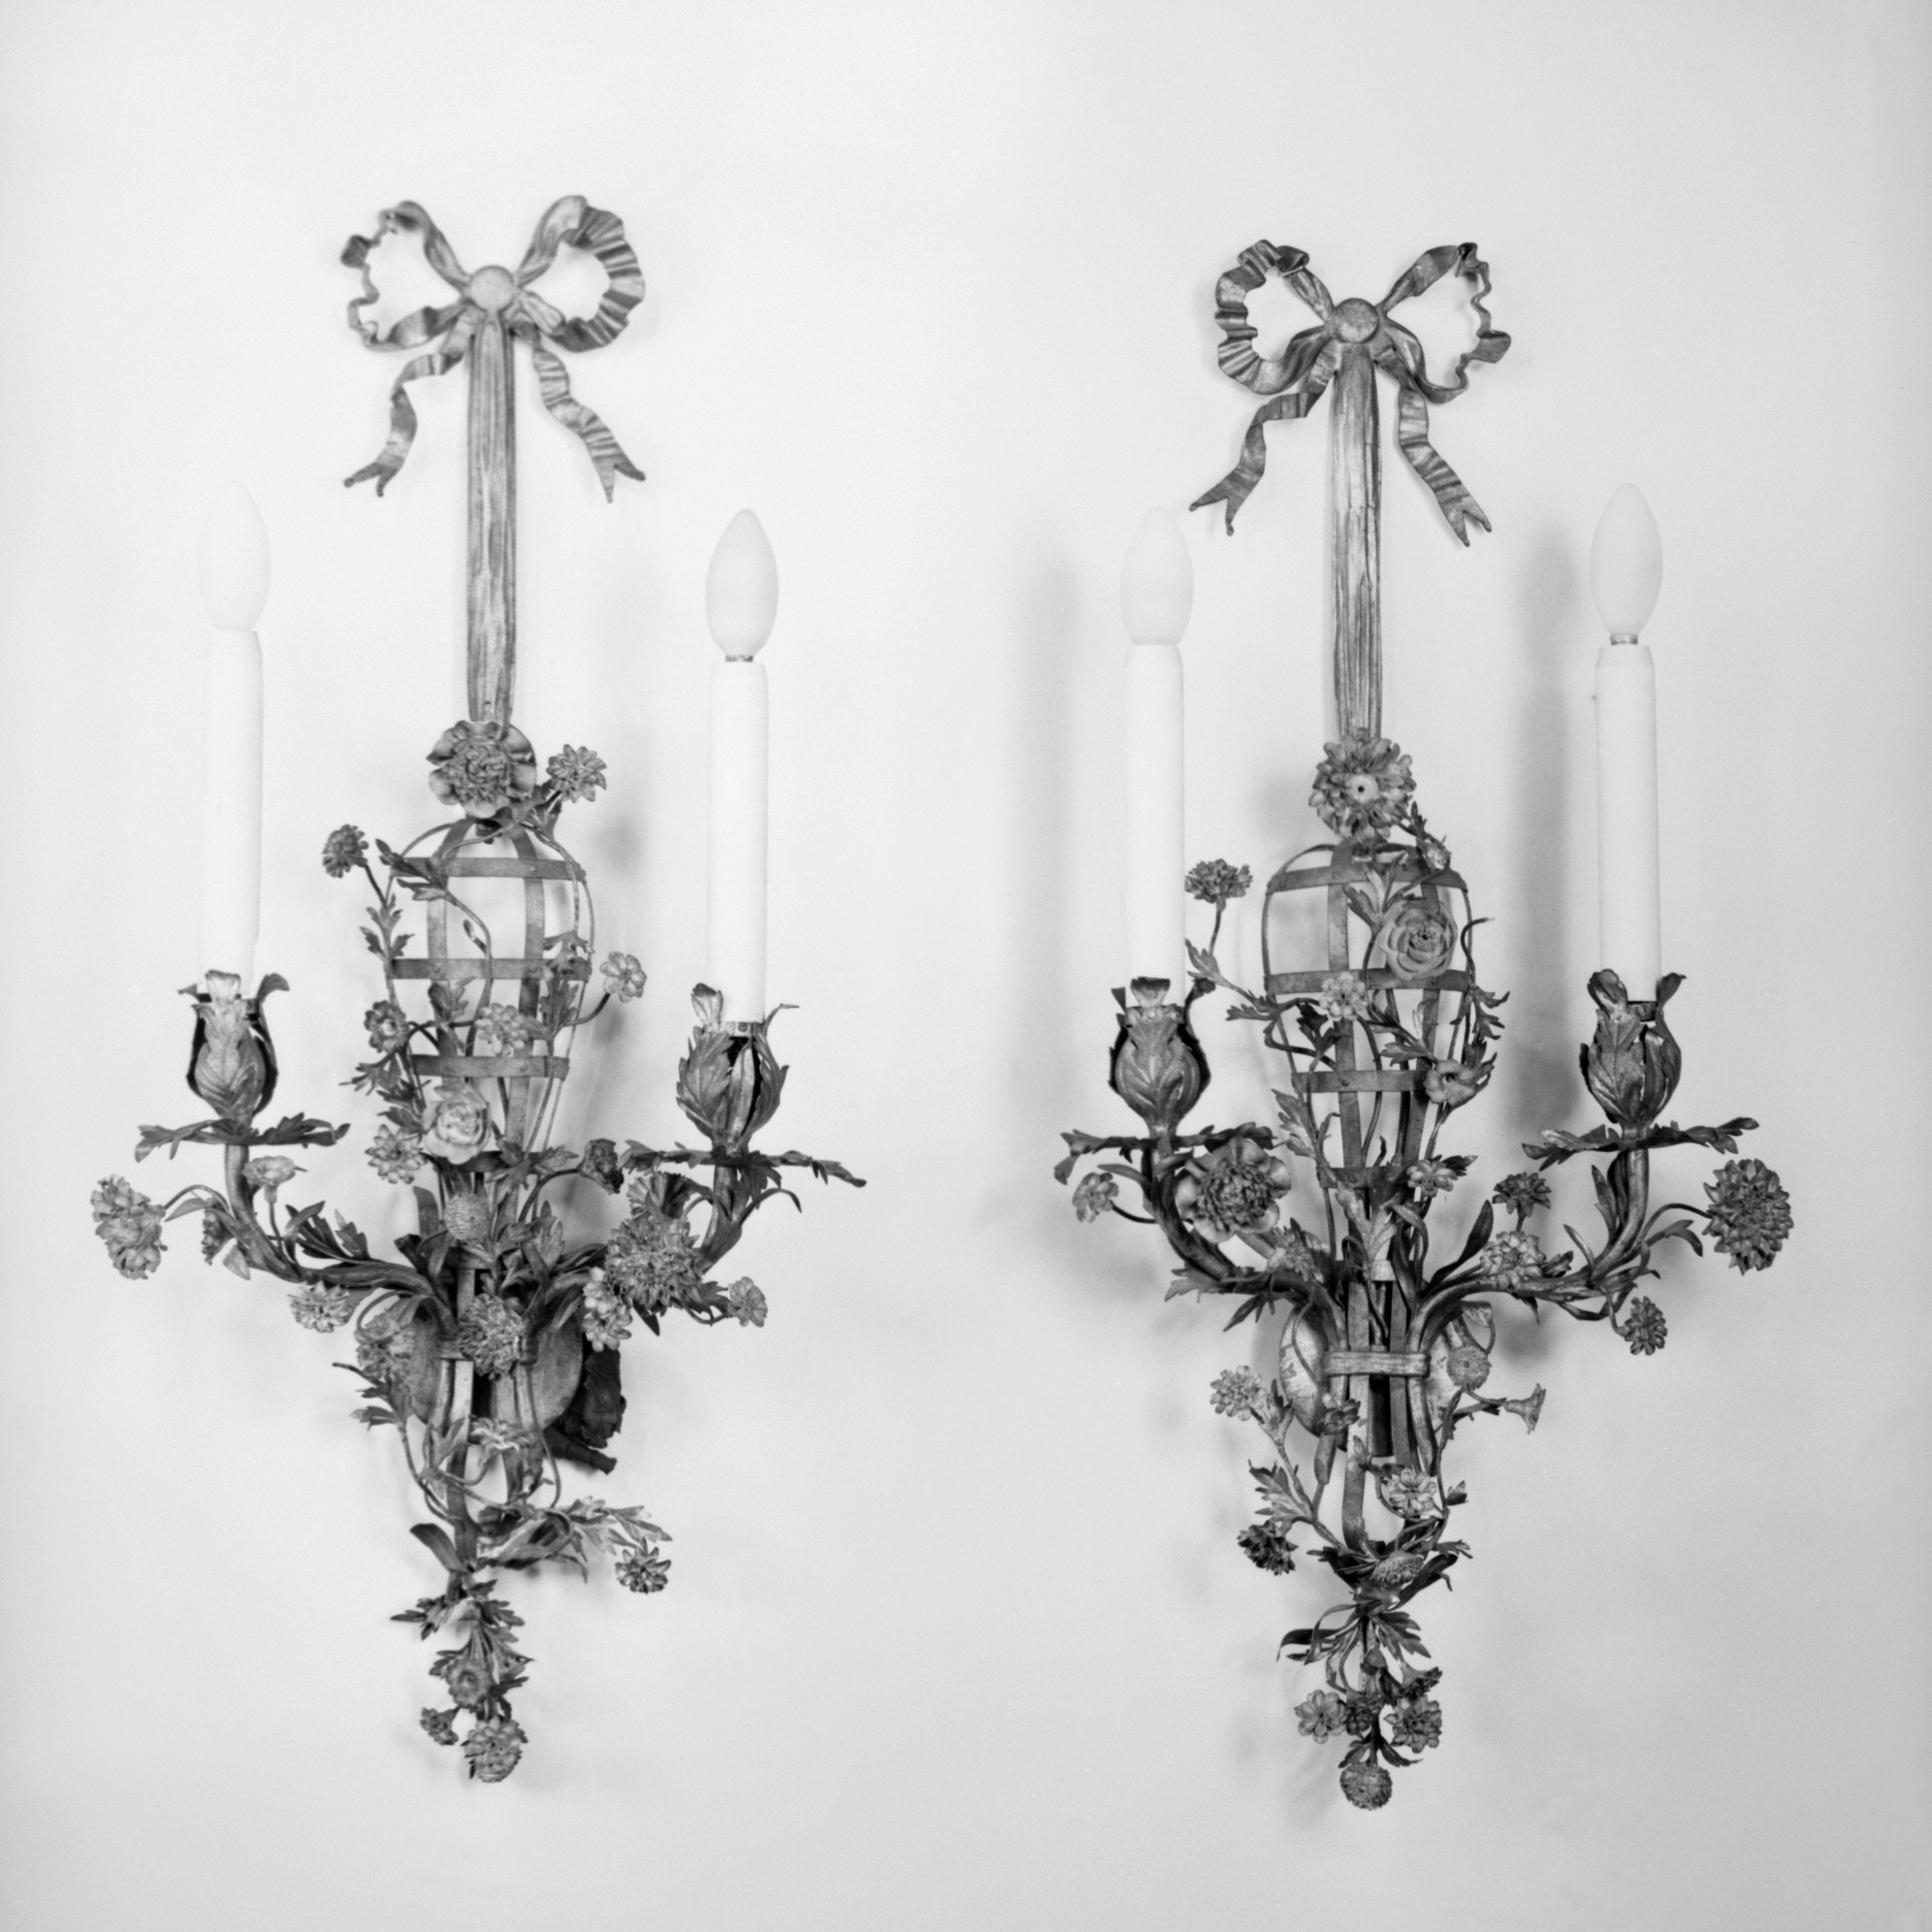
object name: wall sconce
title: Pair of wall sconces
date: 1751-1775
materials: brass, gilt, porcelain